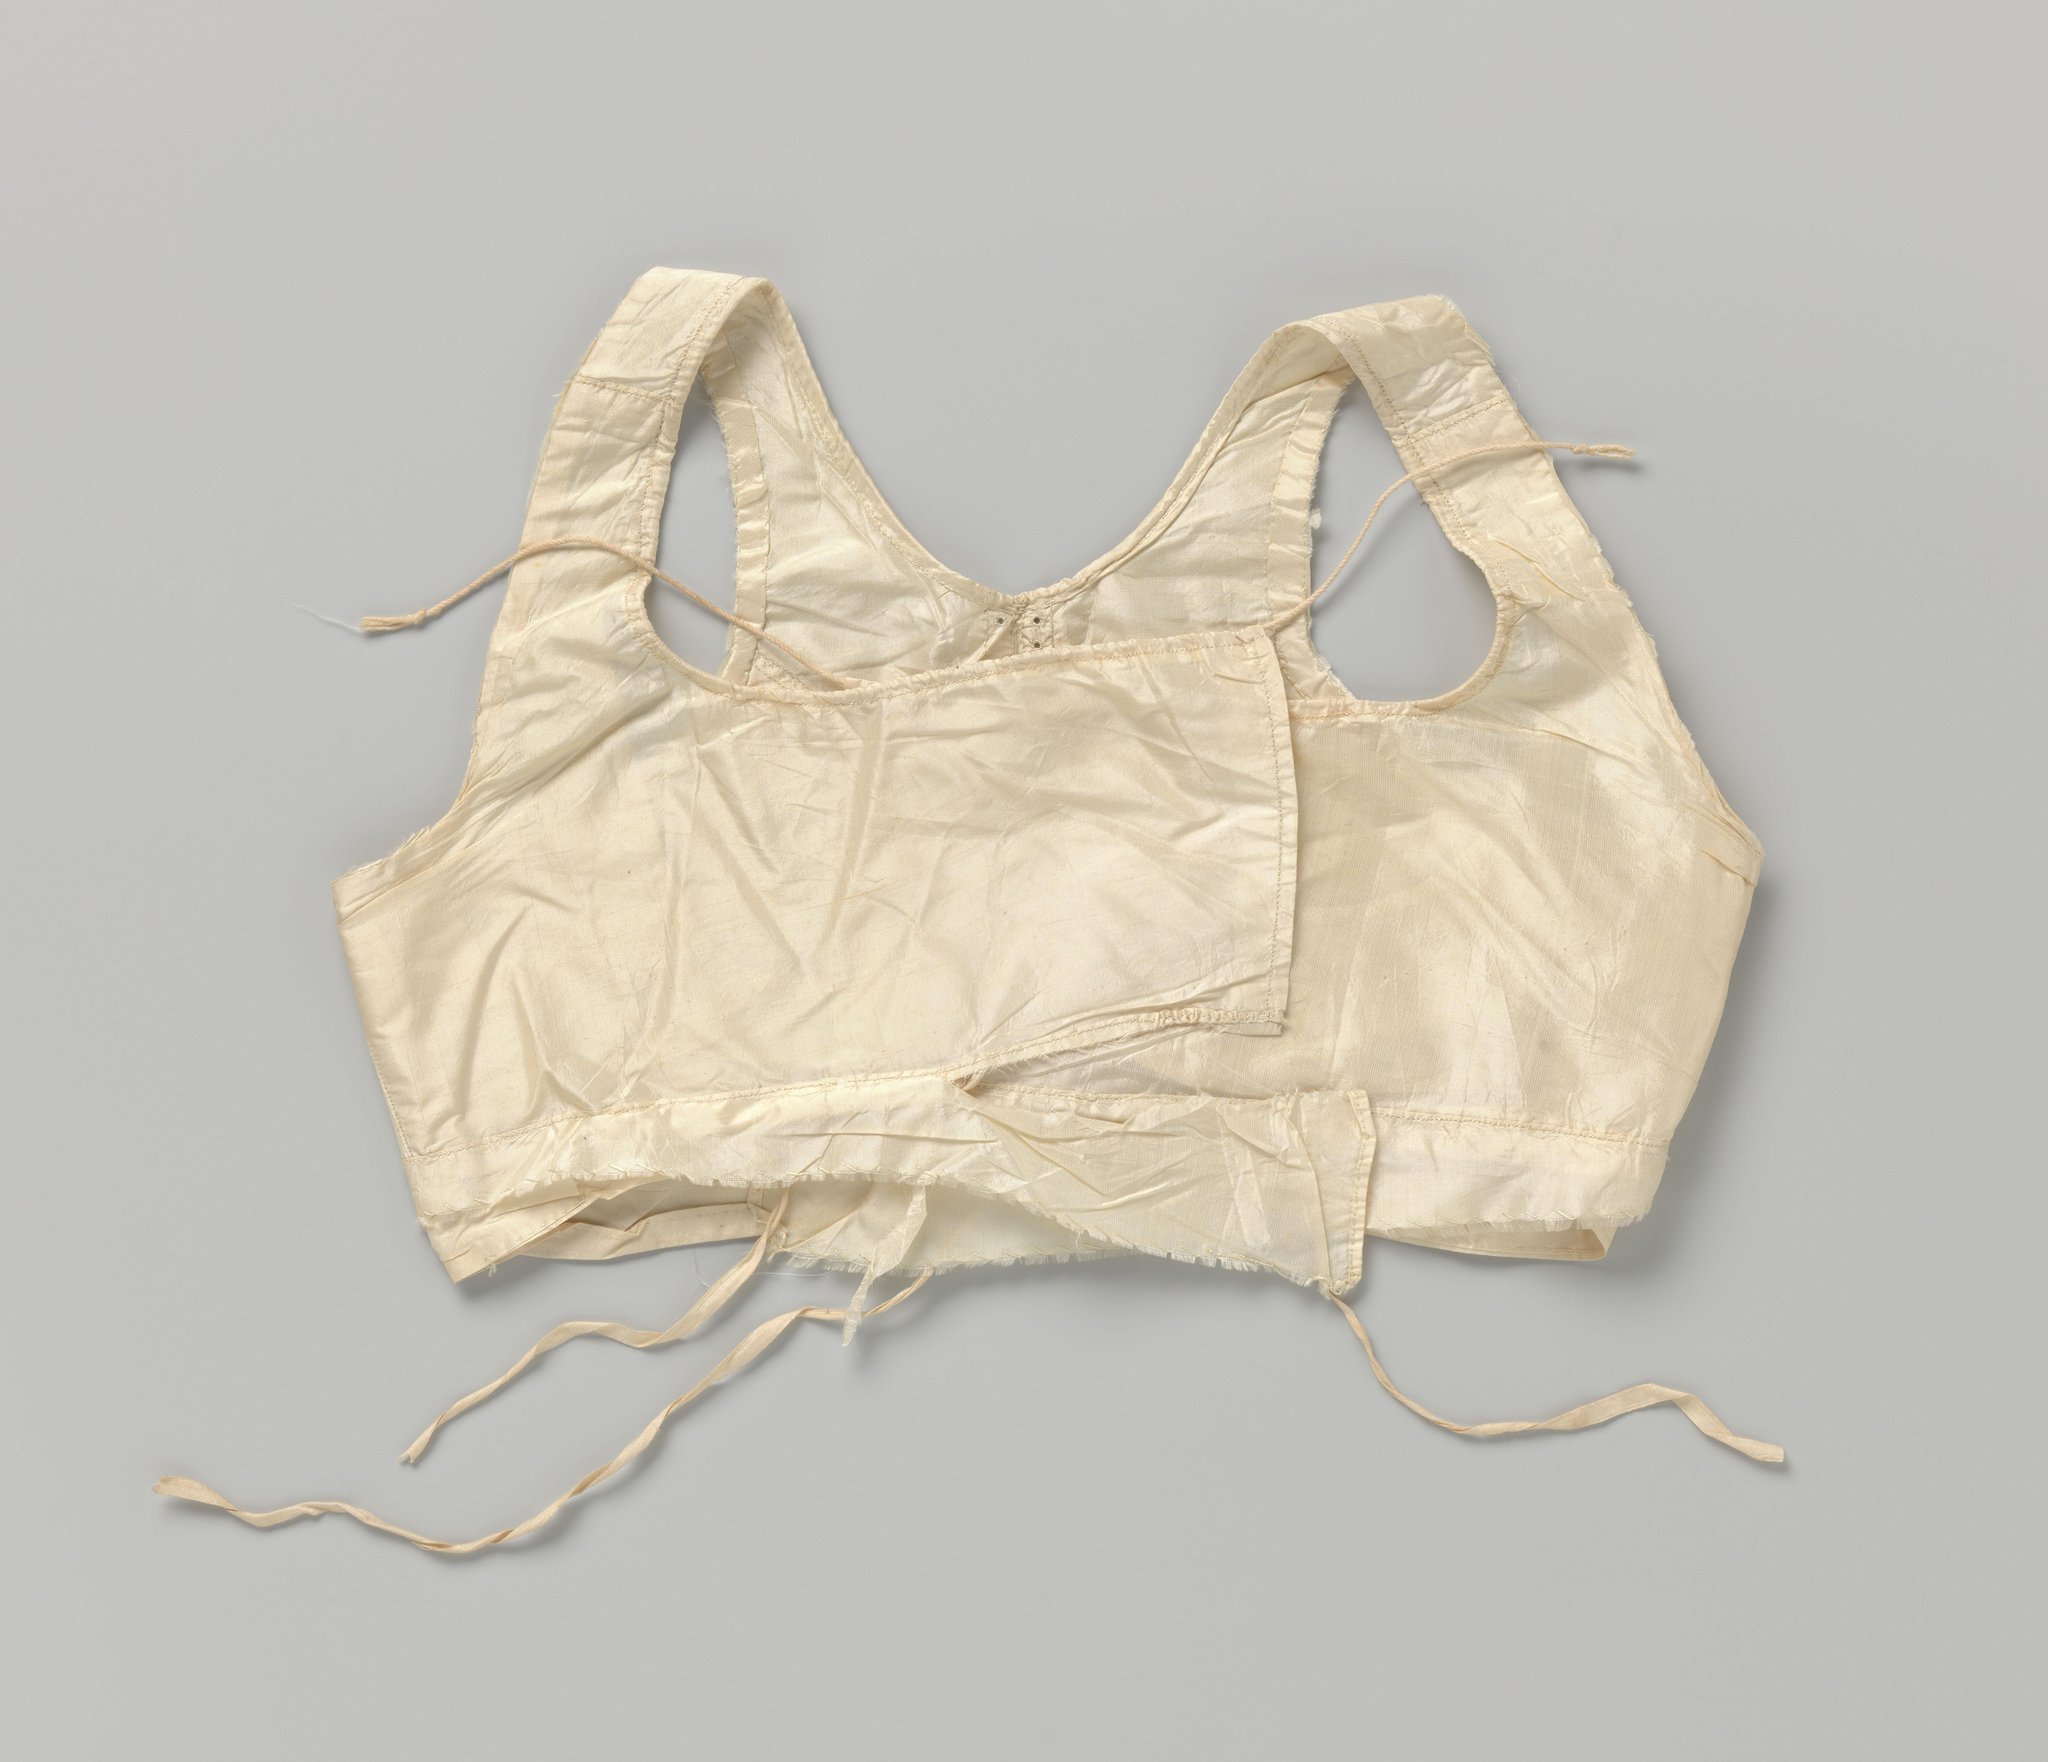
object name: corsage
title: Lijf van een empire-japon van dunne witte tafzijde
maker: Anonymous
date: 1805-1810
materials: silk, textile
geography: netherlands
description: Lijf van een empire-japon van dunne witte tafzijde, onversierd. Zeer hoog middel en een diepuitgesneden décolleté. Gladde voorpanden en een zeer smal vliergervormig rugpand, dat door vetergaatjes tot een quasi-rijglijfje is gemaakt. Een glad binnenlijfje, alleen aan de voorzijde meegenaaid in de zijnaden. Aan het middel nog resten van de rok. Uit de armsgaten zijn de mouwen geknipt.